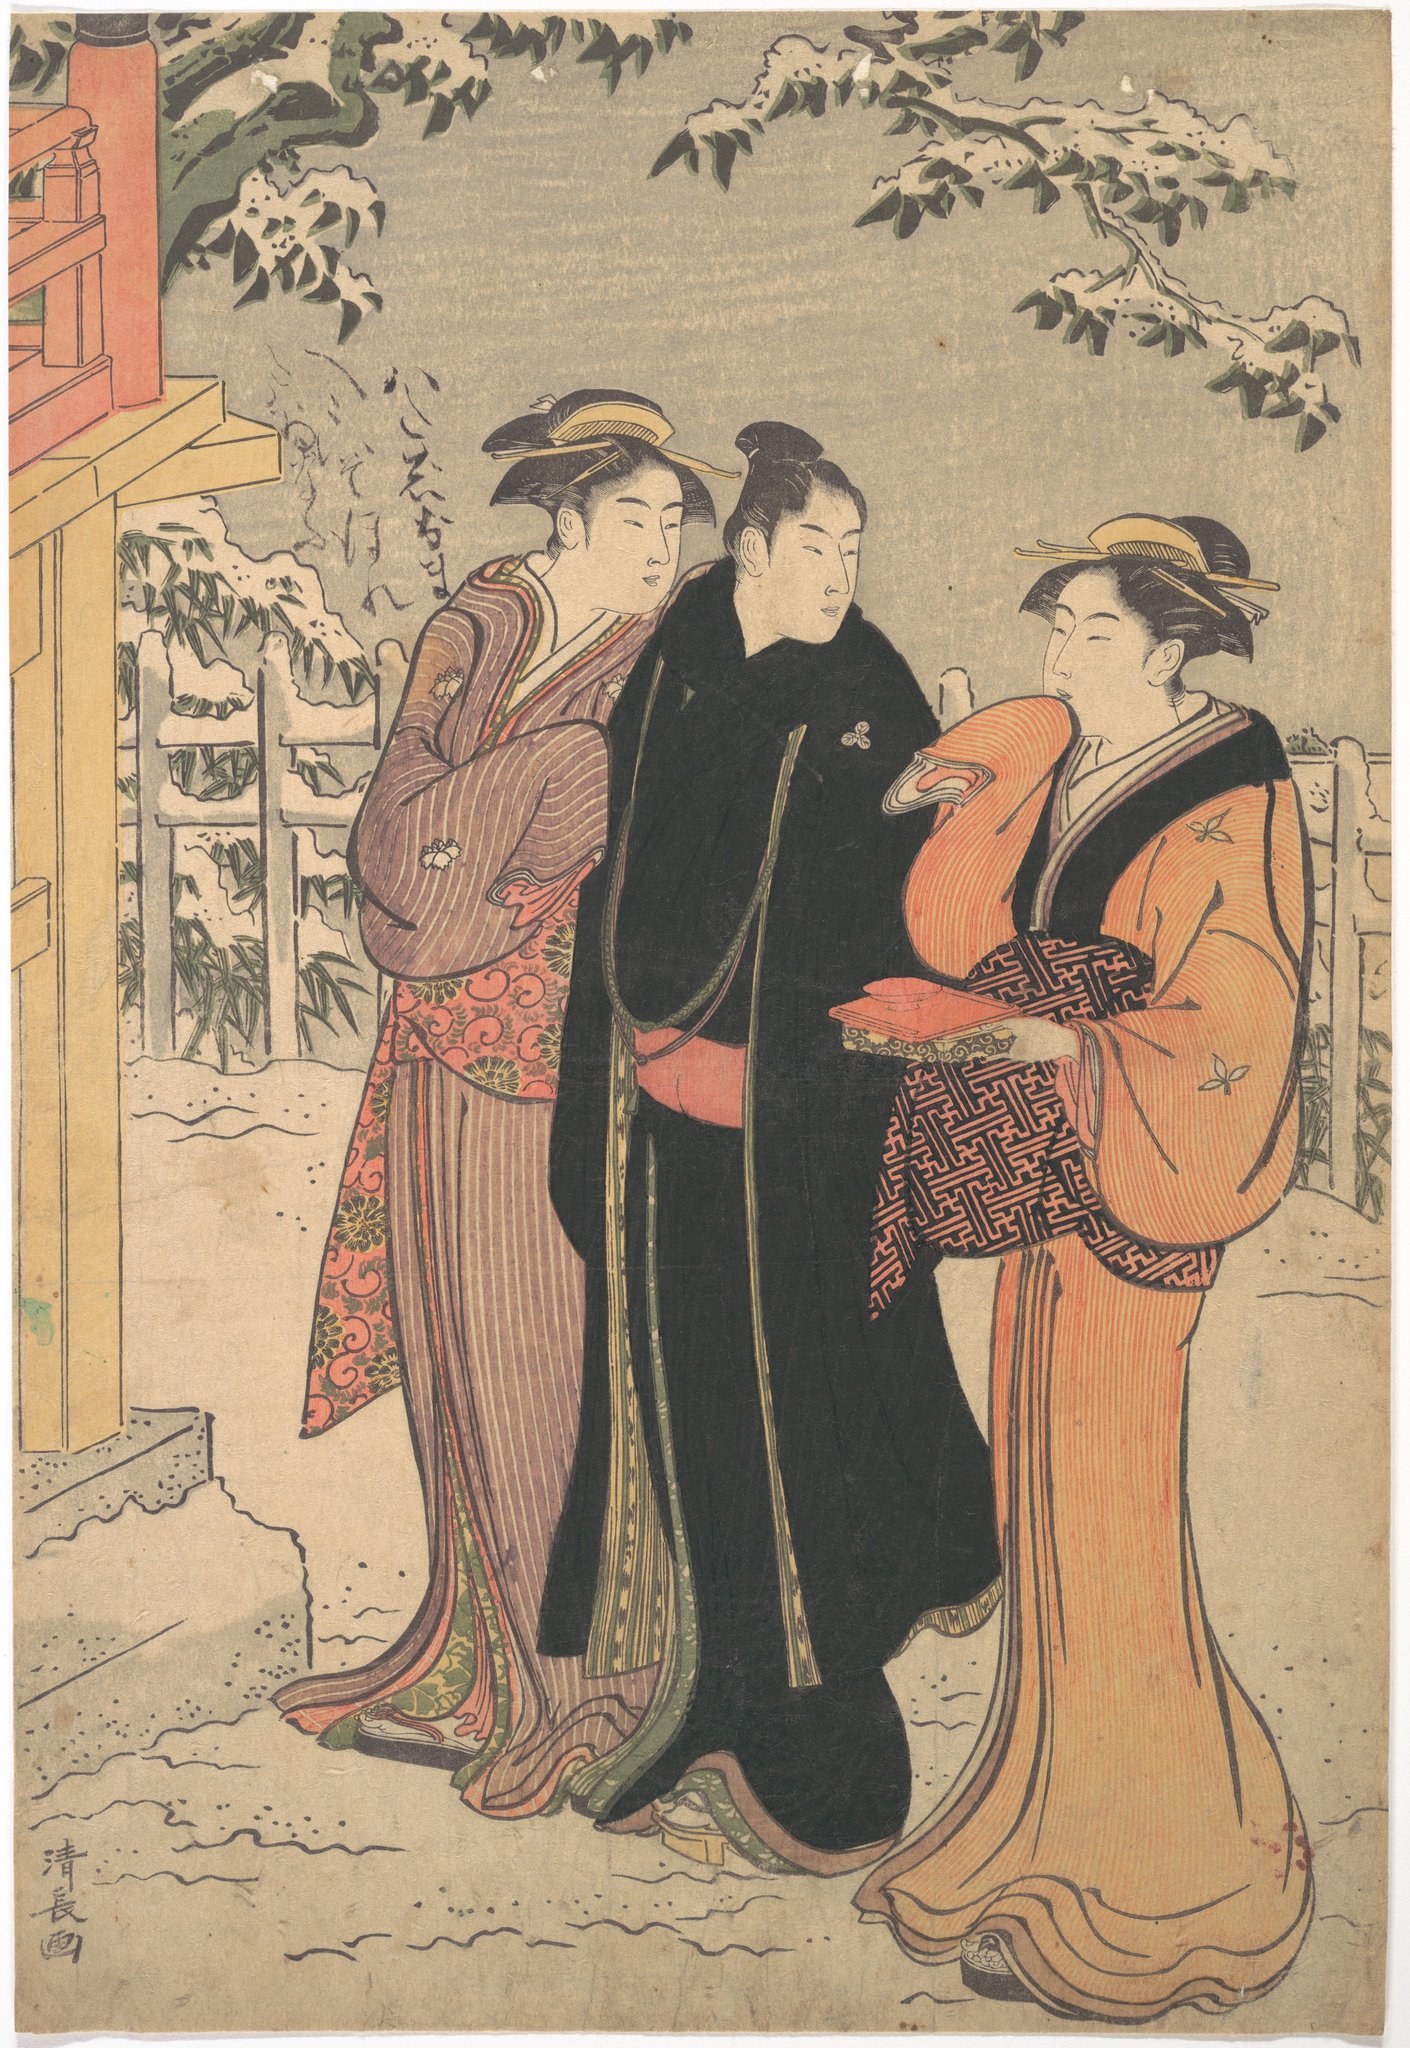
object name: woodblock print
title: Man in a Black Haori (Coat) and Two Women Approaching a Temple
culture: japanese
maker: torii kiyonaga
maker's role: artist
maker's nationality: japanese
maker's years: 1752-1815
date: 1742-1815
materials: ink, paper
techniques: woodblock print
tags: men,women